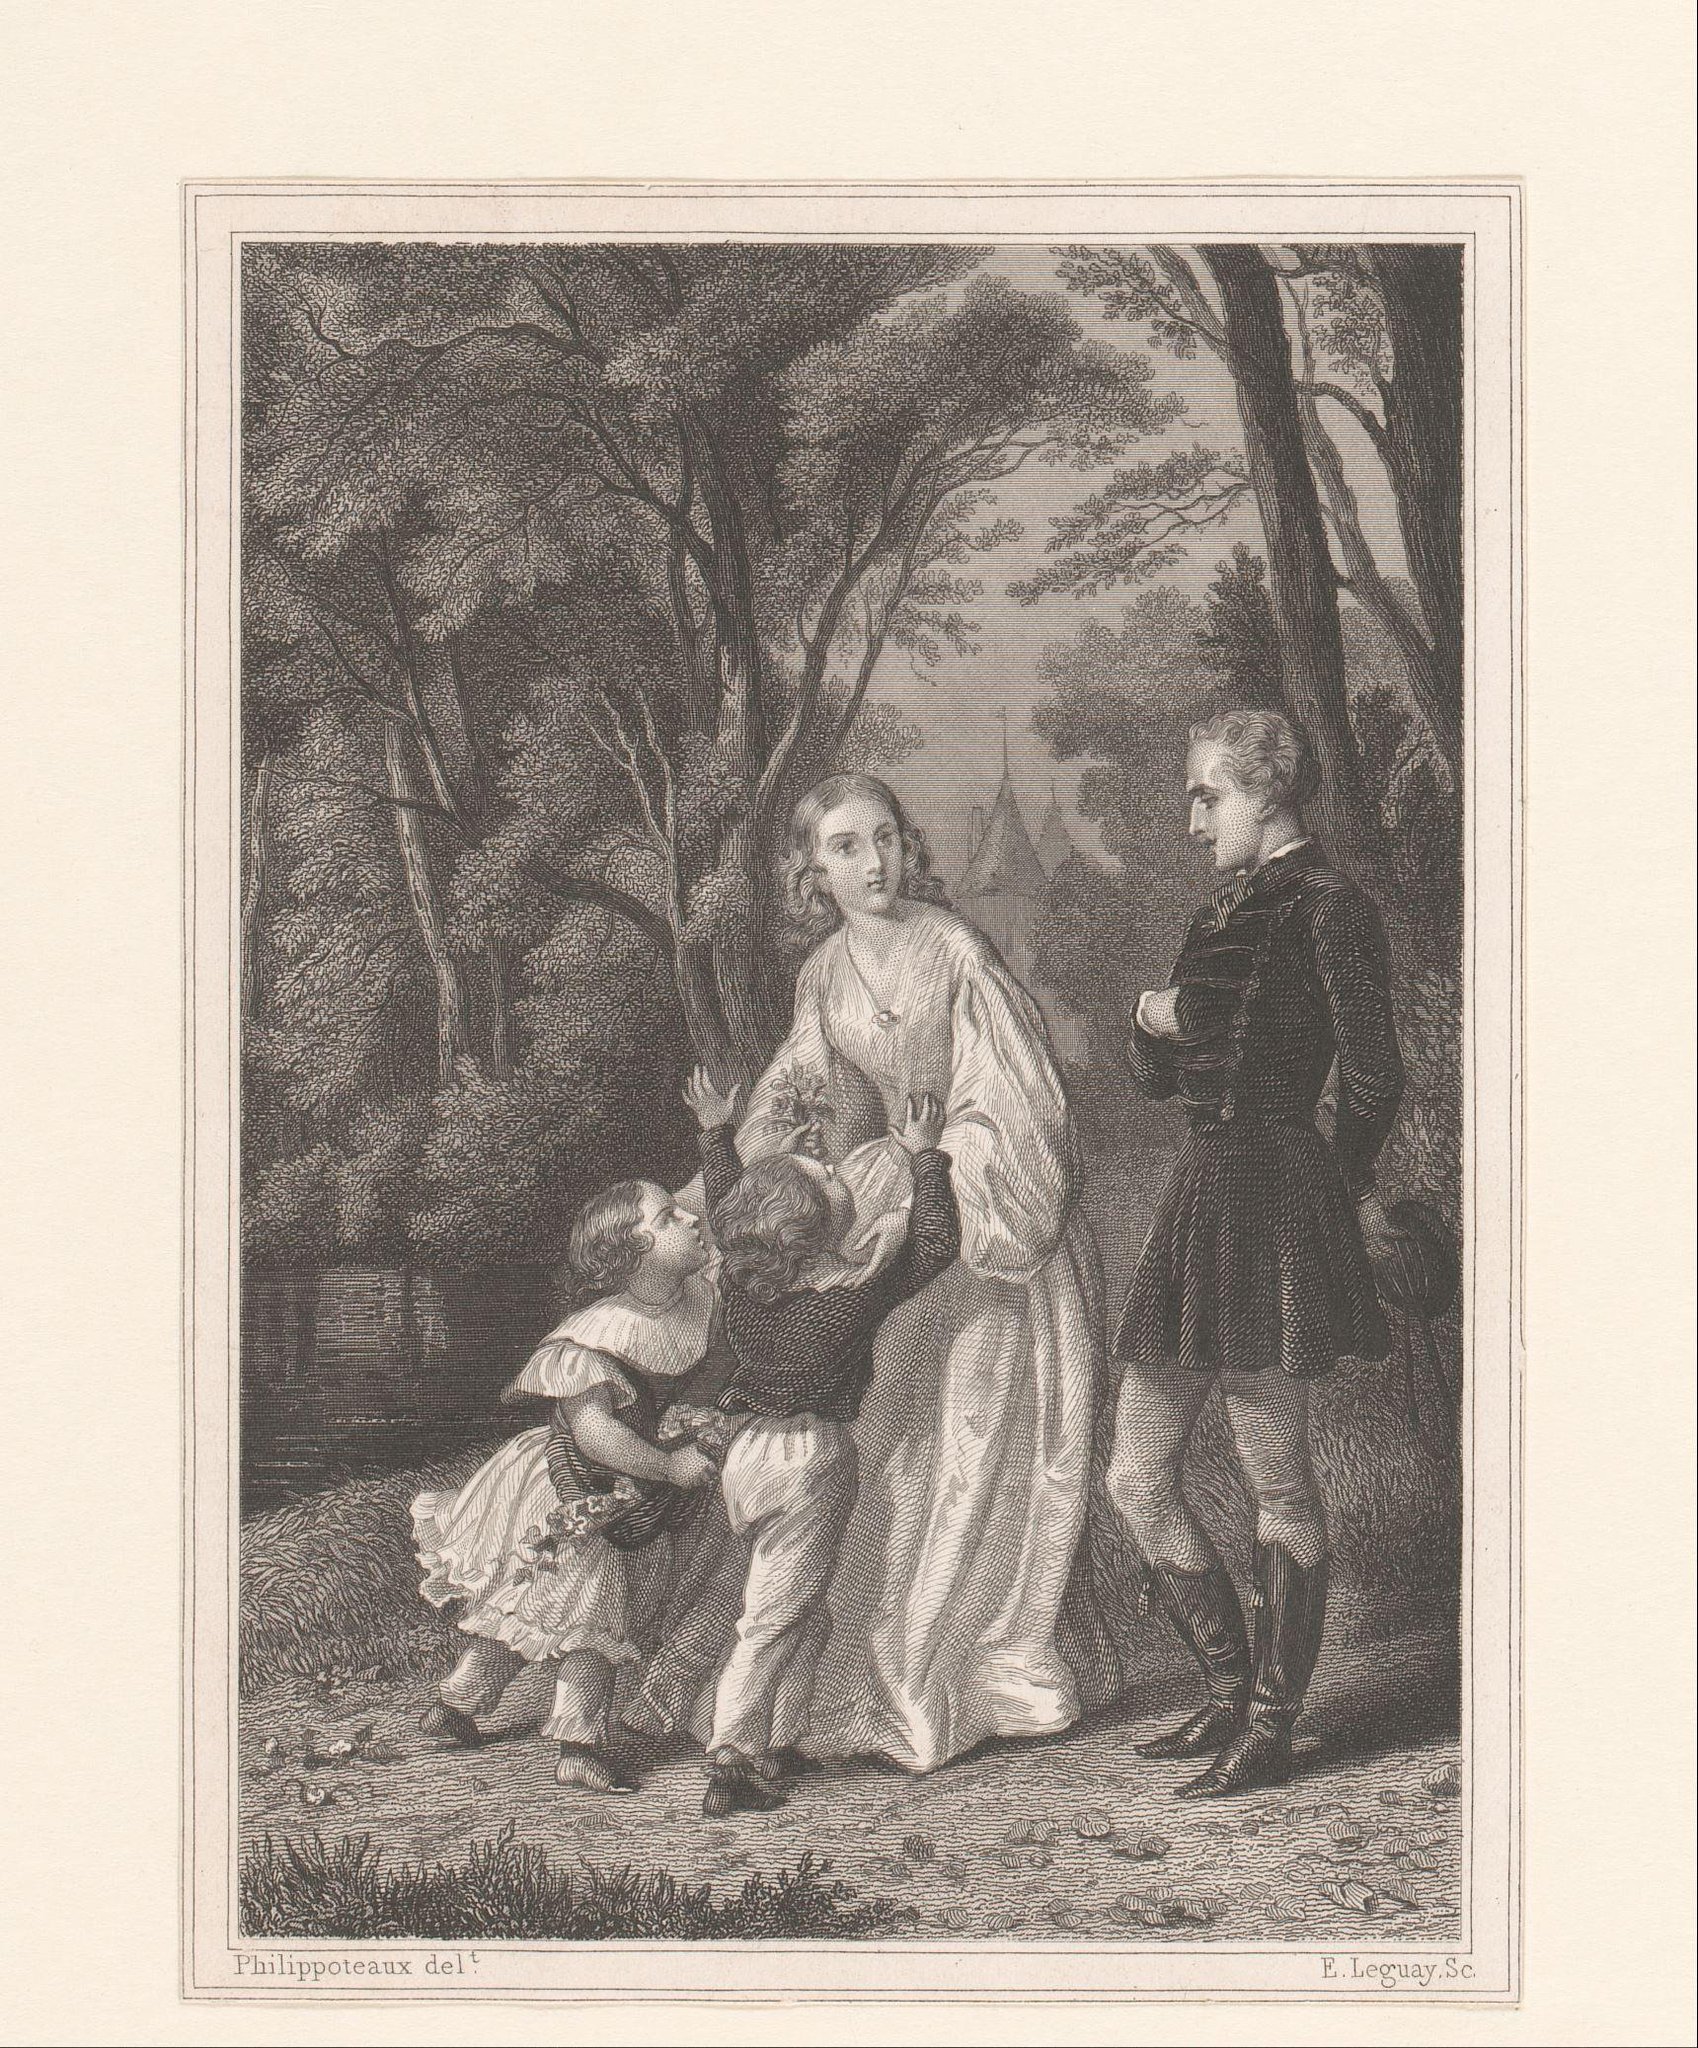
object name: print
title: Man en vrouw met twee kinderen in een landschap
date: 1832-1905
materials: paper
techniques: engraving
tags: landscapes with waters, waterscapes, seascapes (in the temperate zone), parents (first degree family relationships)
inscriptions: collector's mark: Lugt 2228